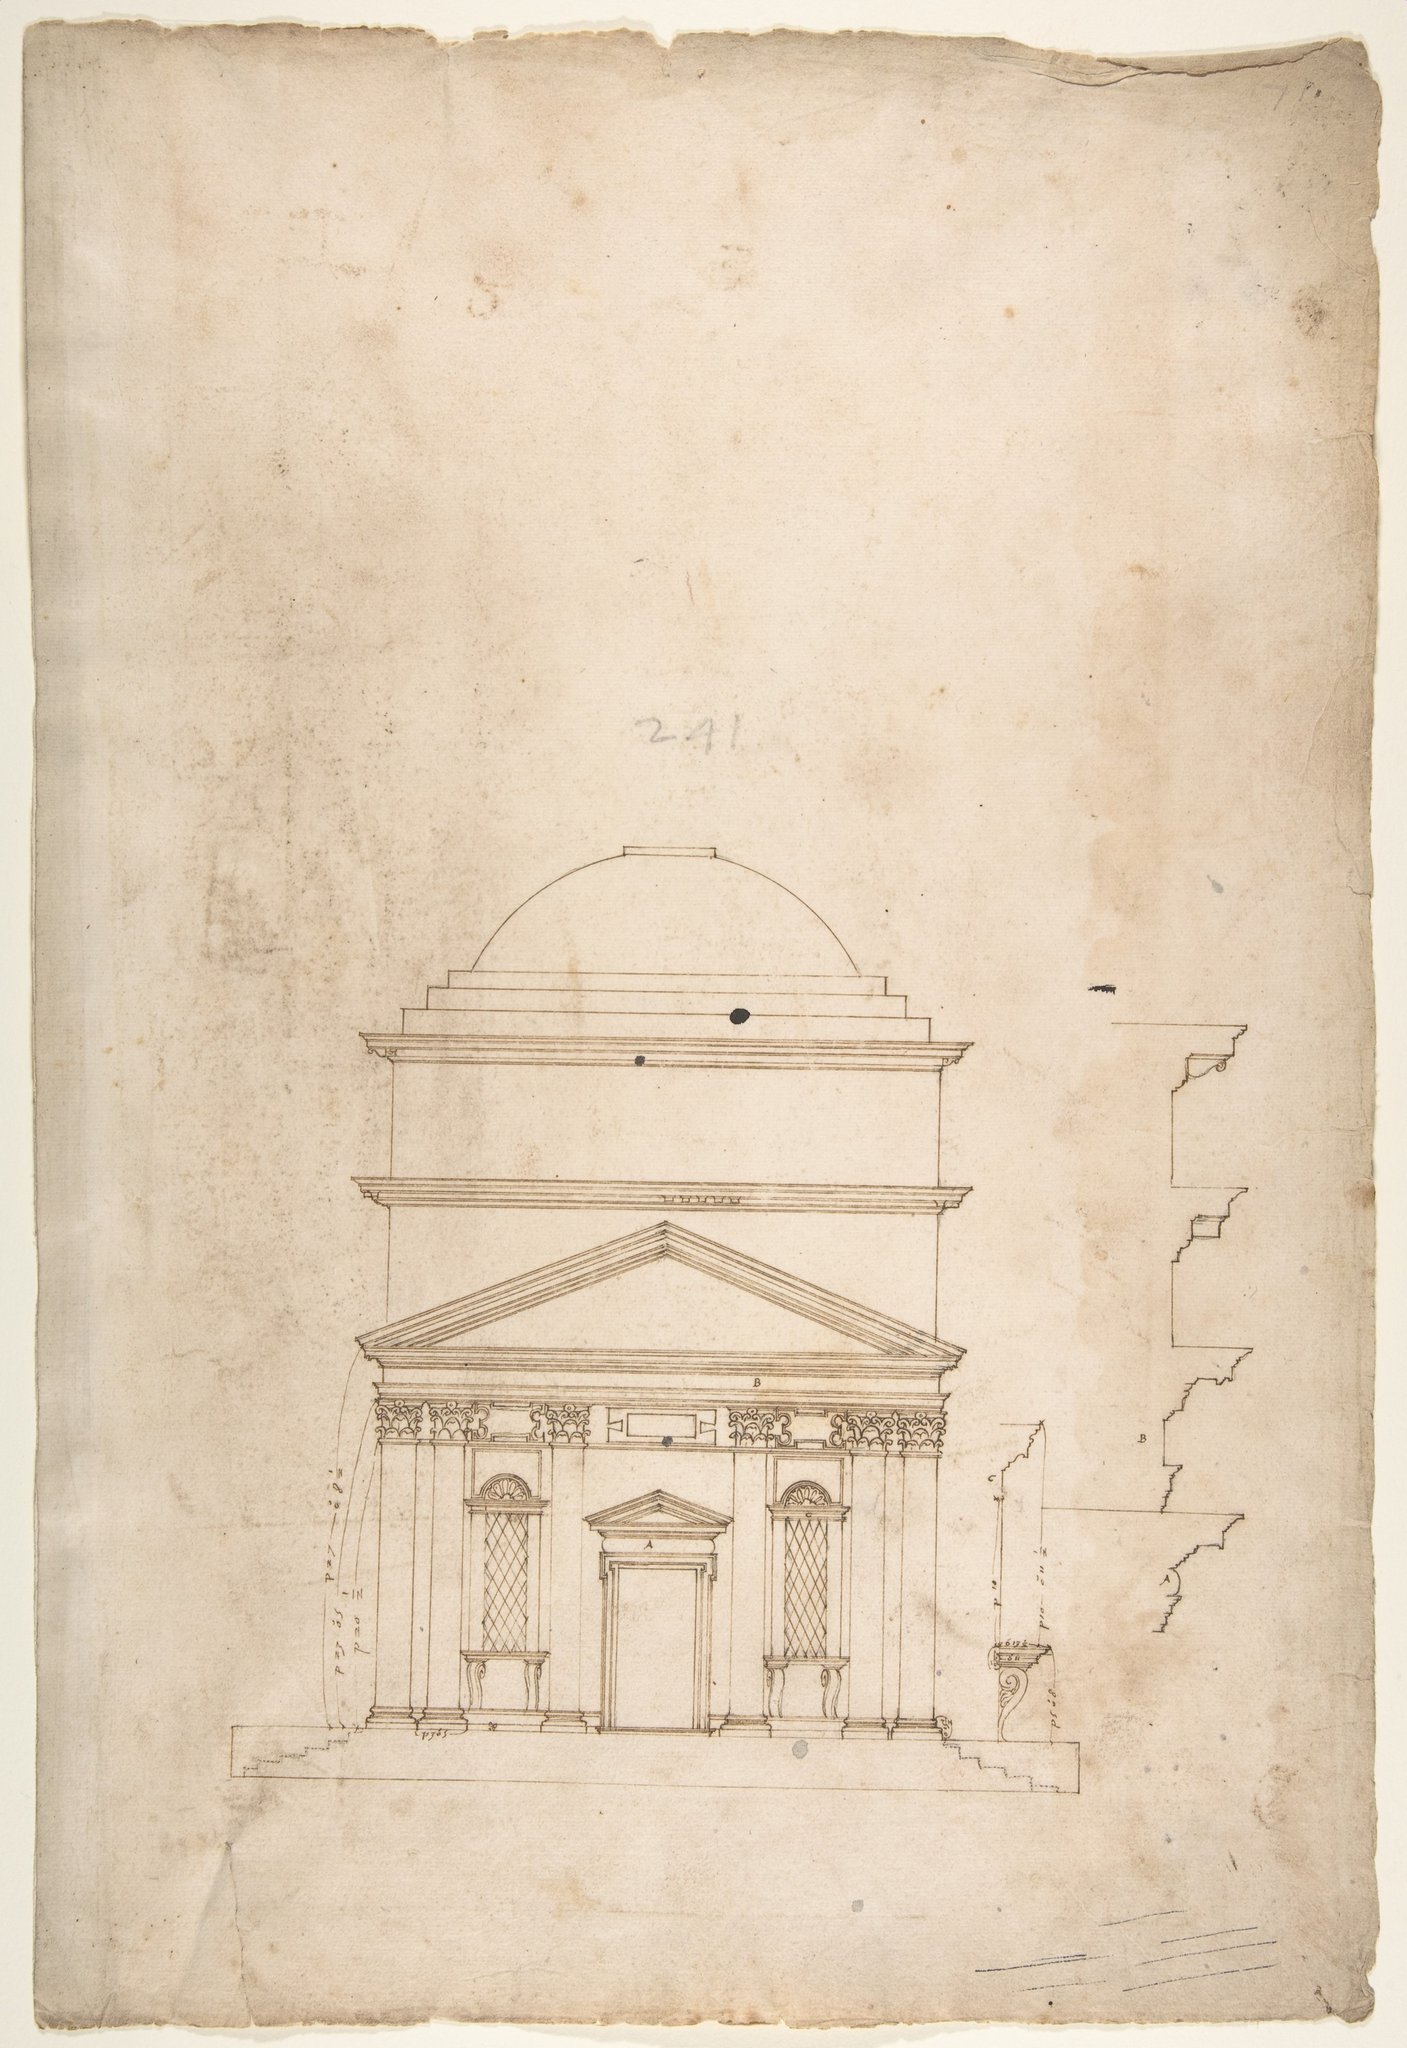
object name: drawing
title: S. Andrea via Flaminia, elevation (recto) blank (verso)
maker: anonymous, french, 16th century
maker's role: draftsman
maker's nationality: french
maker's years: 1500-1600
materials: chalk, ink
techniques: incising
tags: architecture